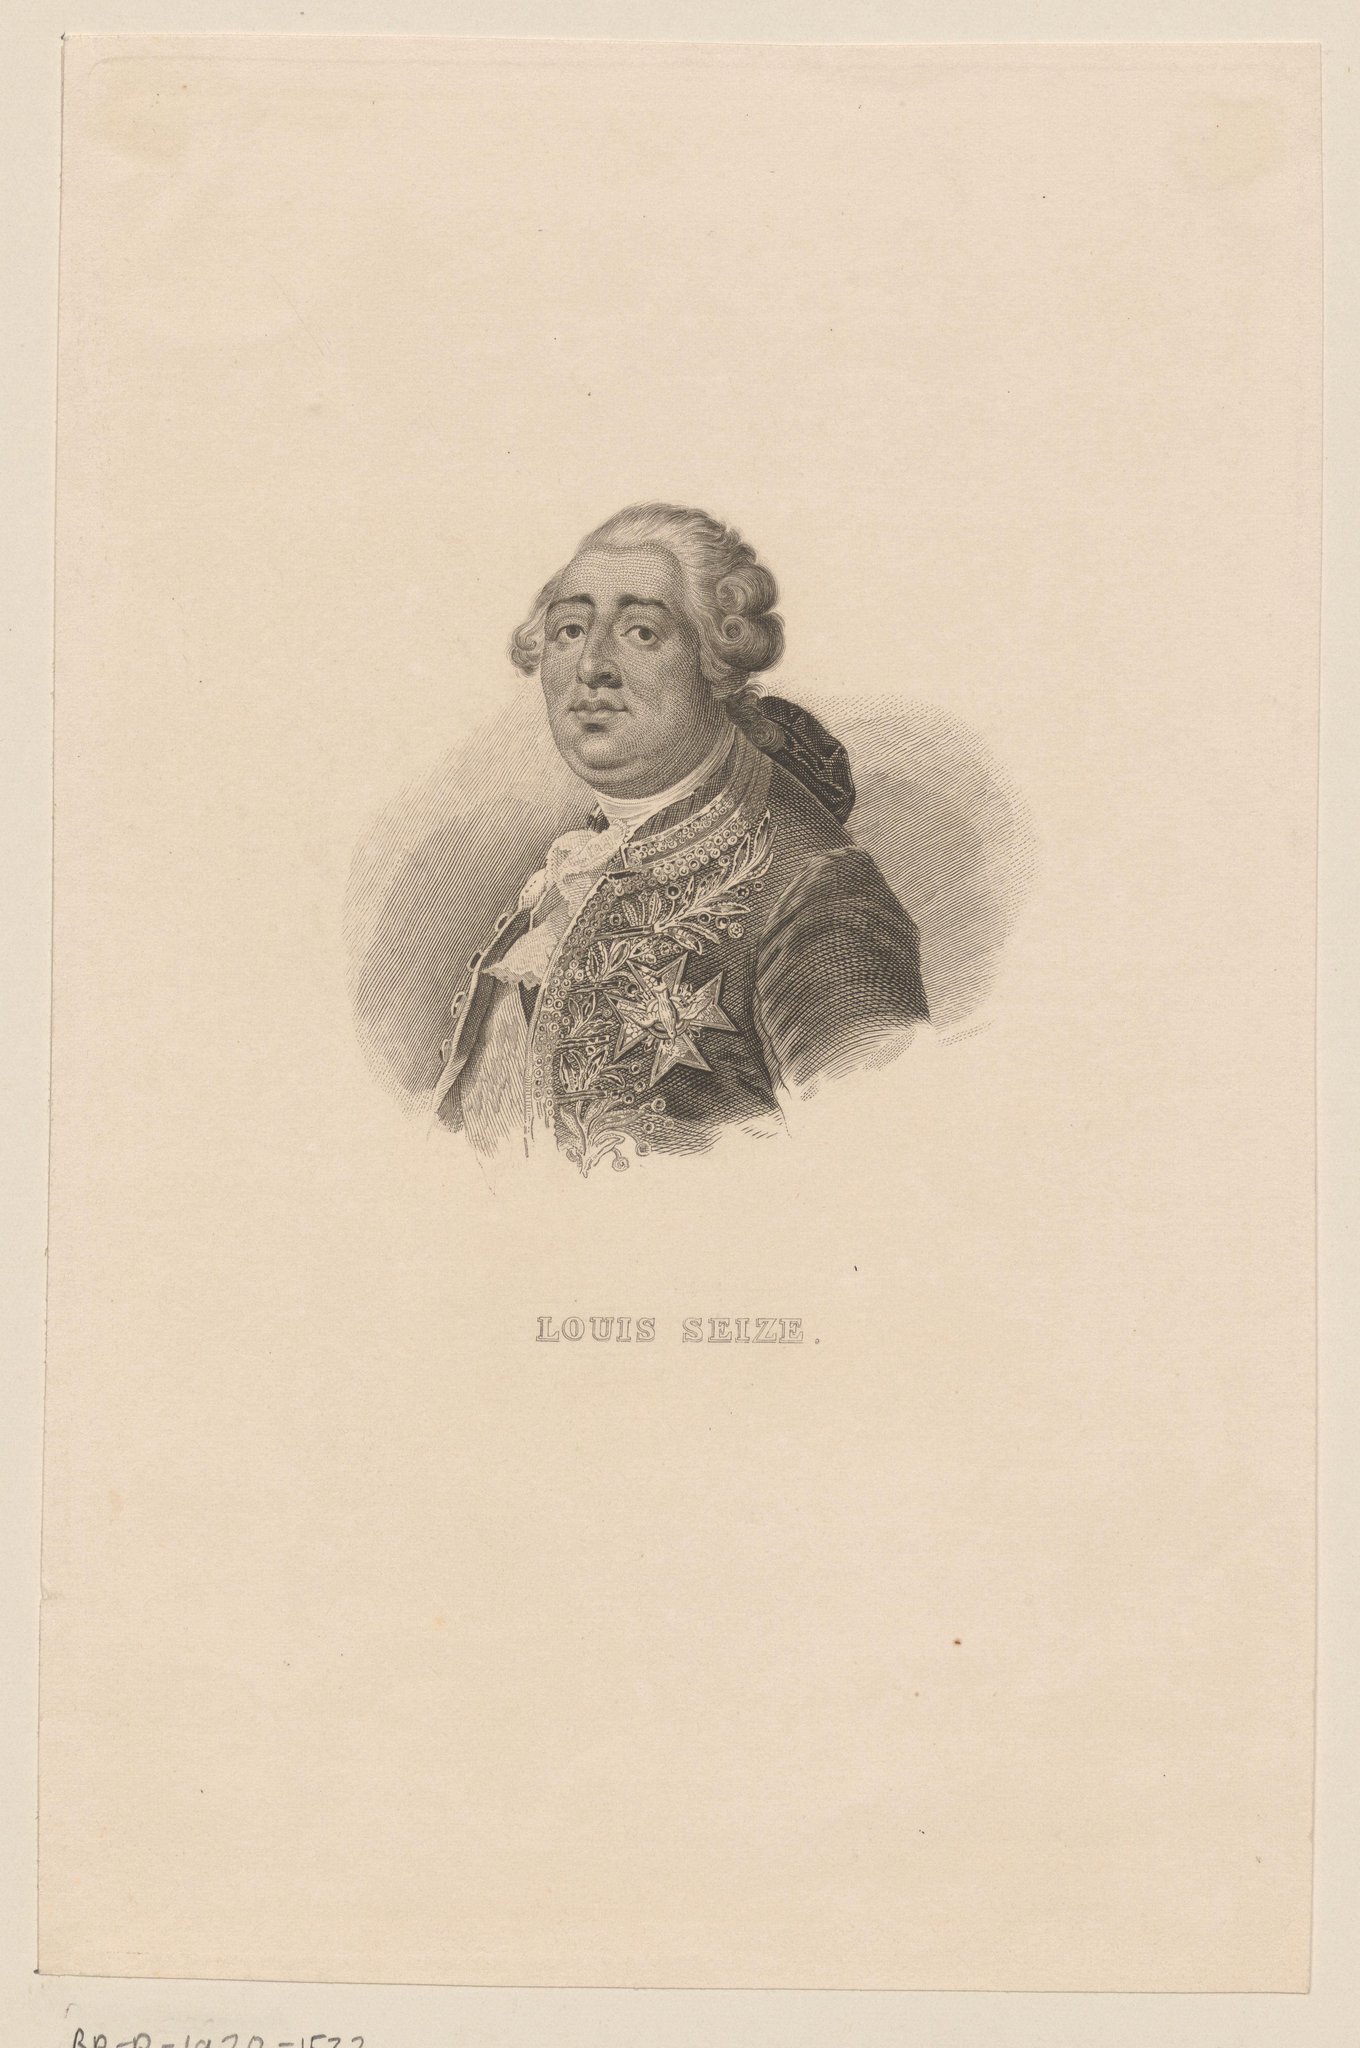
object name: print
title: Portret van Lodewijk XVI van Frankrijk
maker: Anonymous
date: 1820-1899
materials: paper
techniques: etching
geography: france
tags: paris, lodewijk xvi (koning van frankrijk), historical persons, wig, king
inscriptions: collector's mark: Lugt 2228